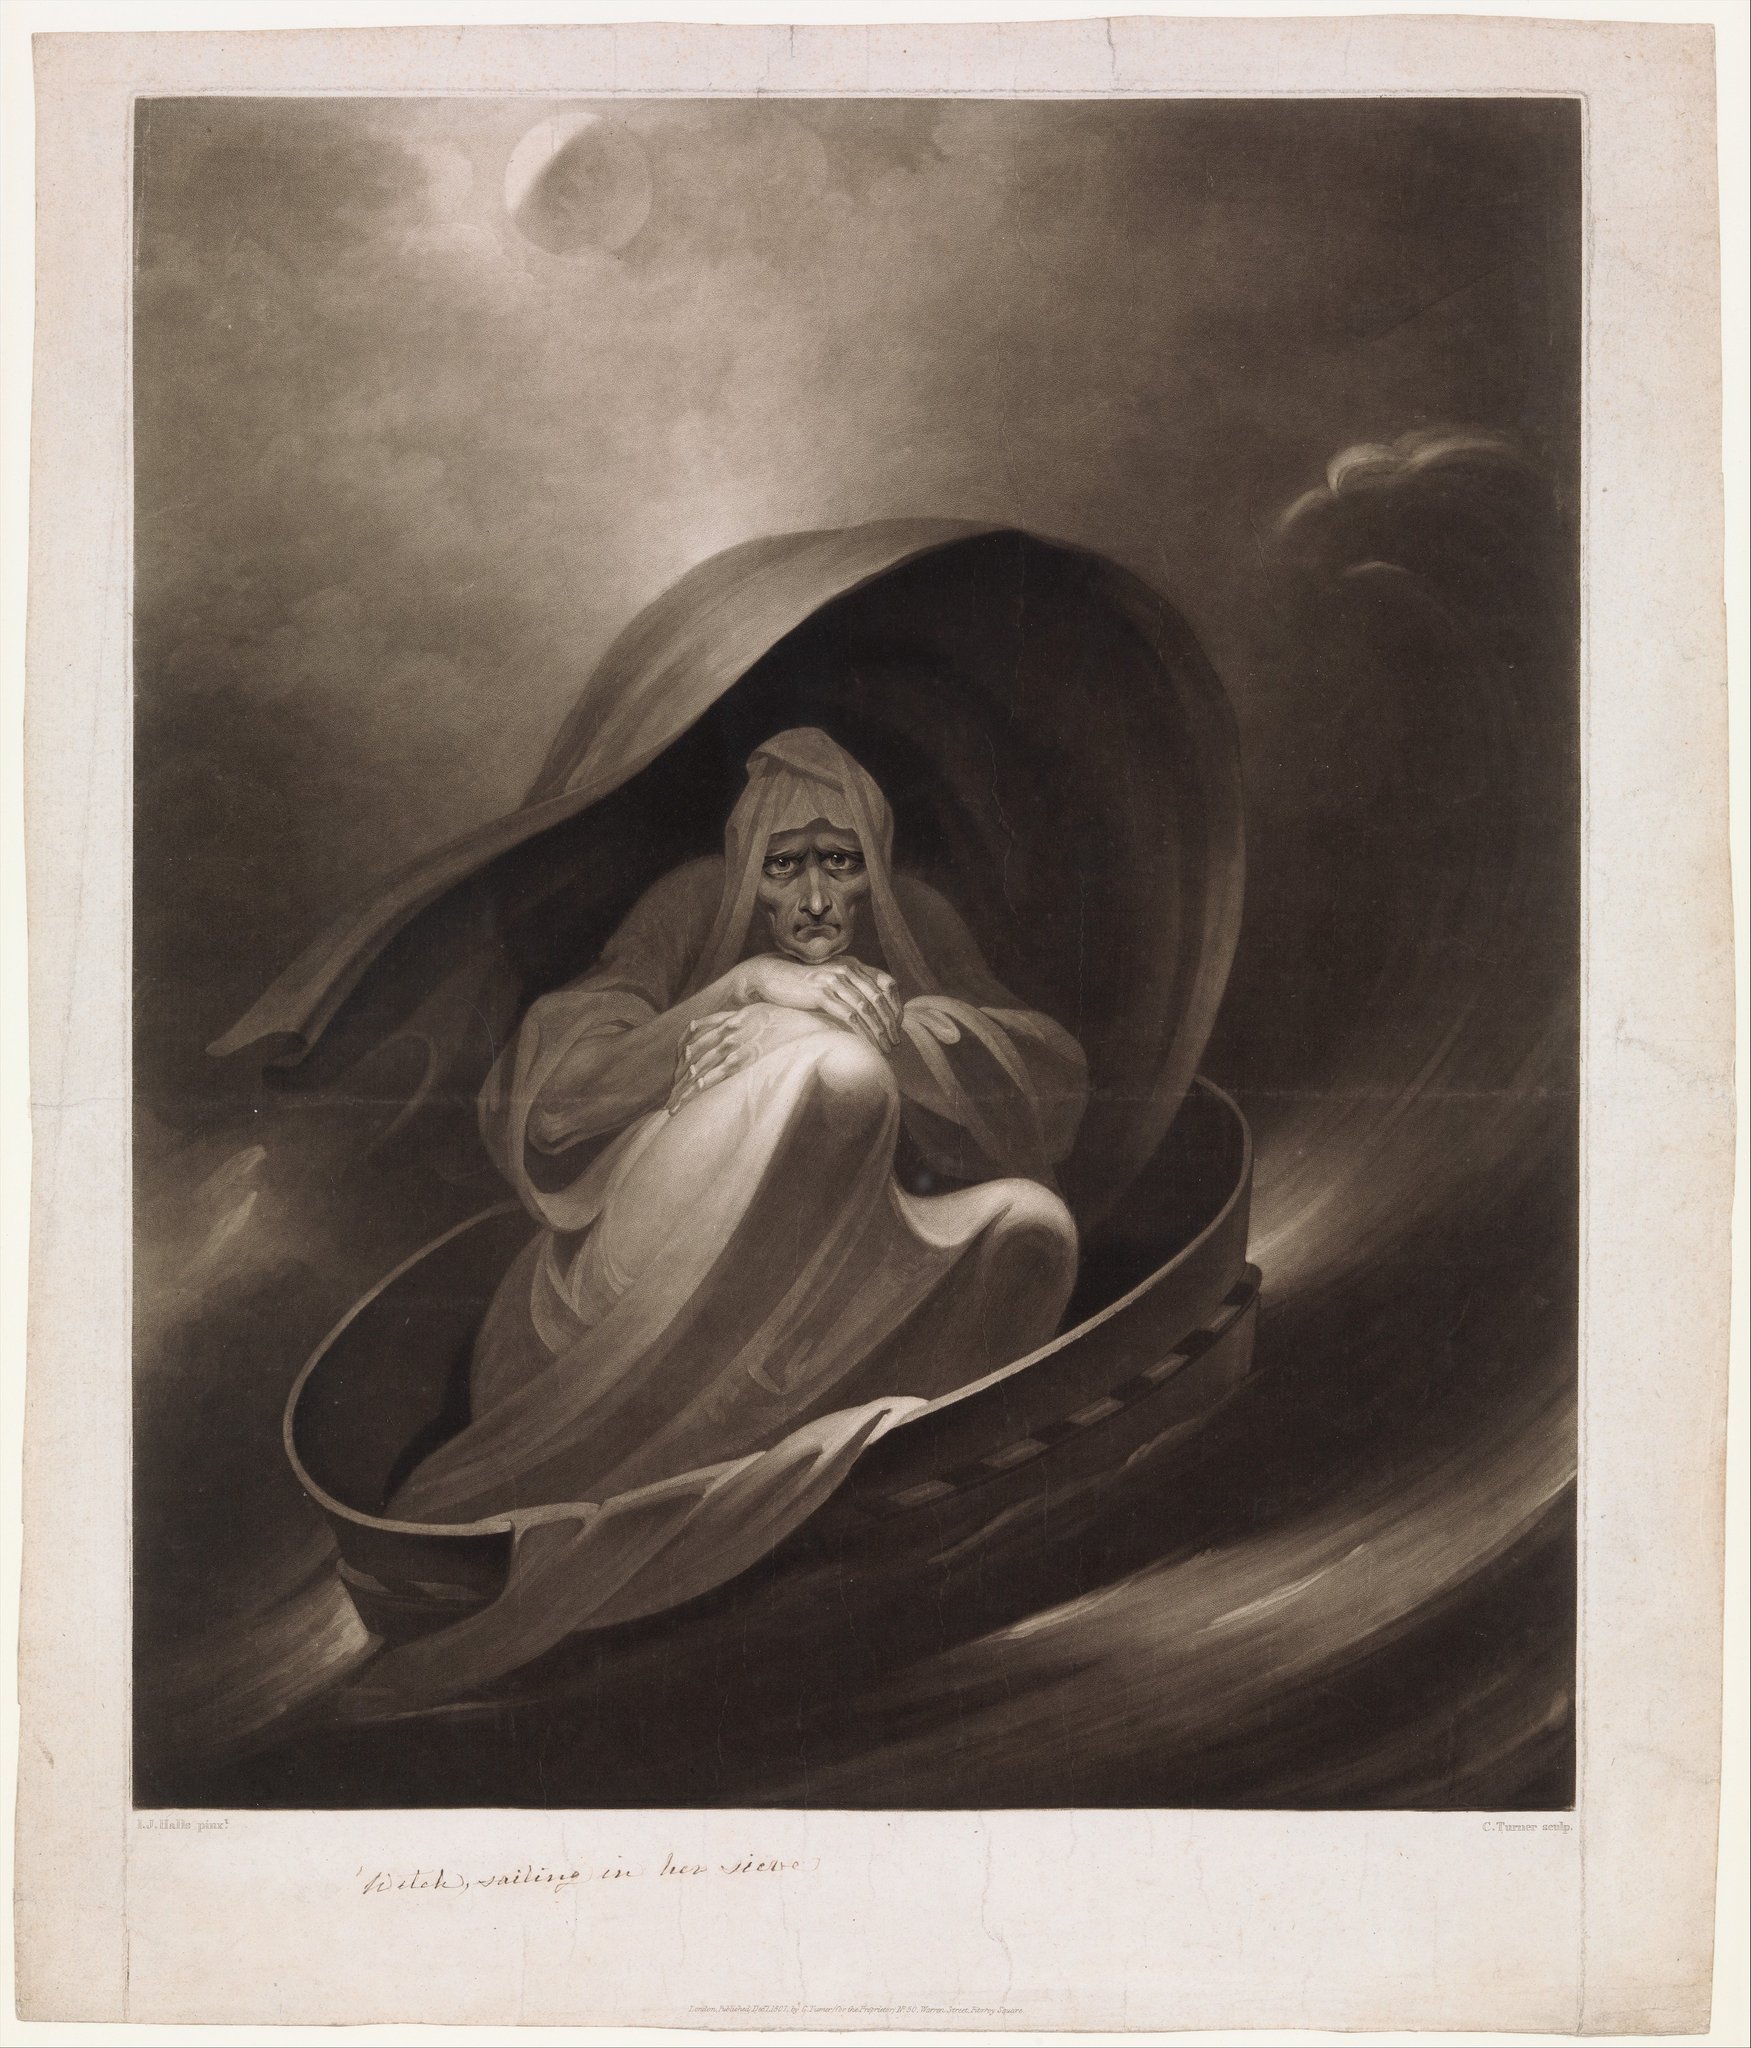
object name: print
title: A Witch Sailing to Aleppo in a Sieve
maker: charles turner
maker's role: artist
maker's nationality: english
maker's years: 1774-1857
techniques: mezzotint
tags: women,witches